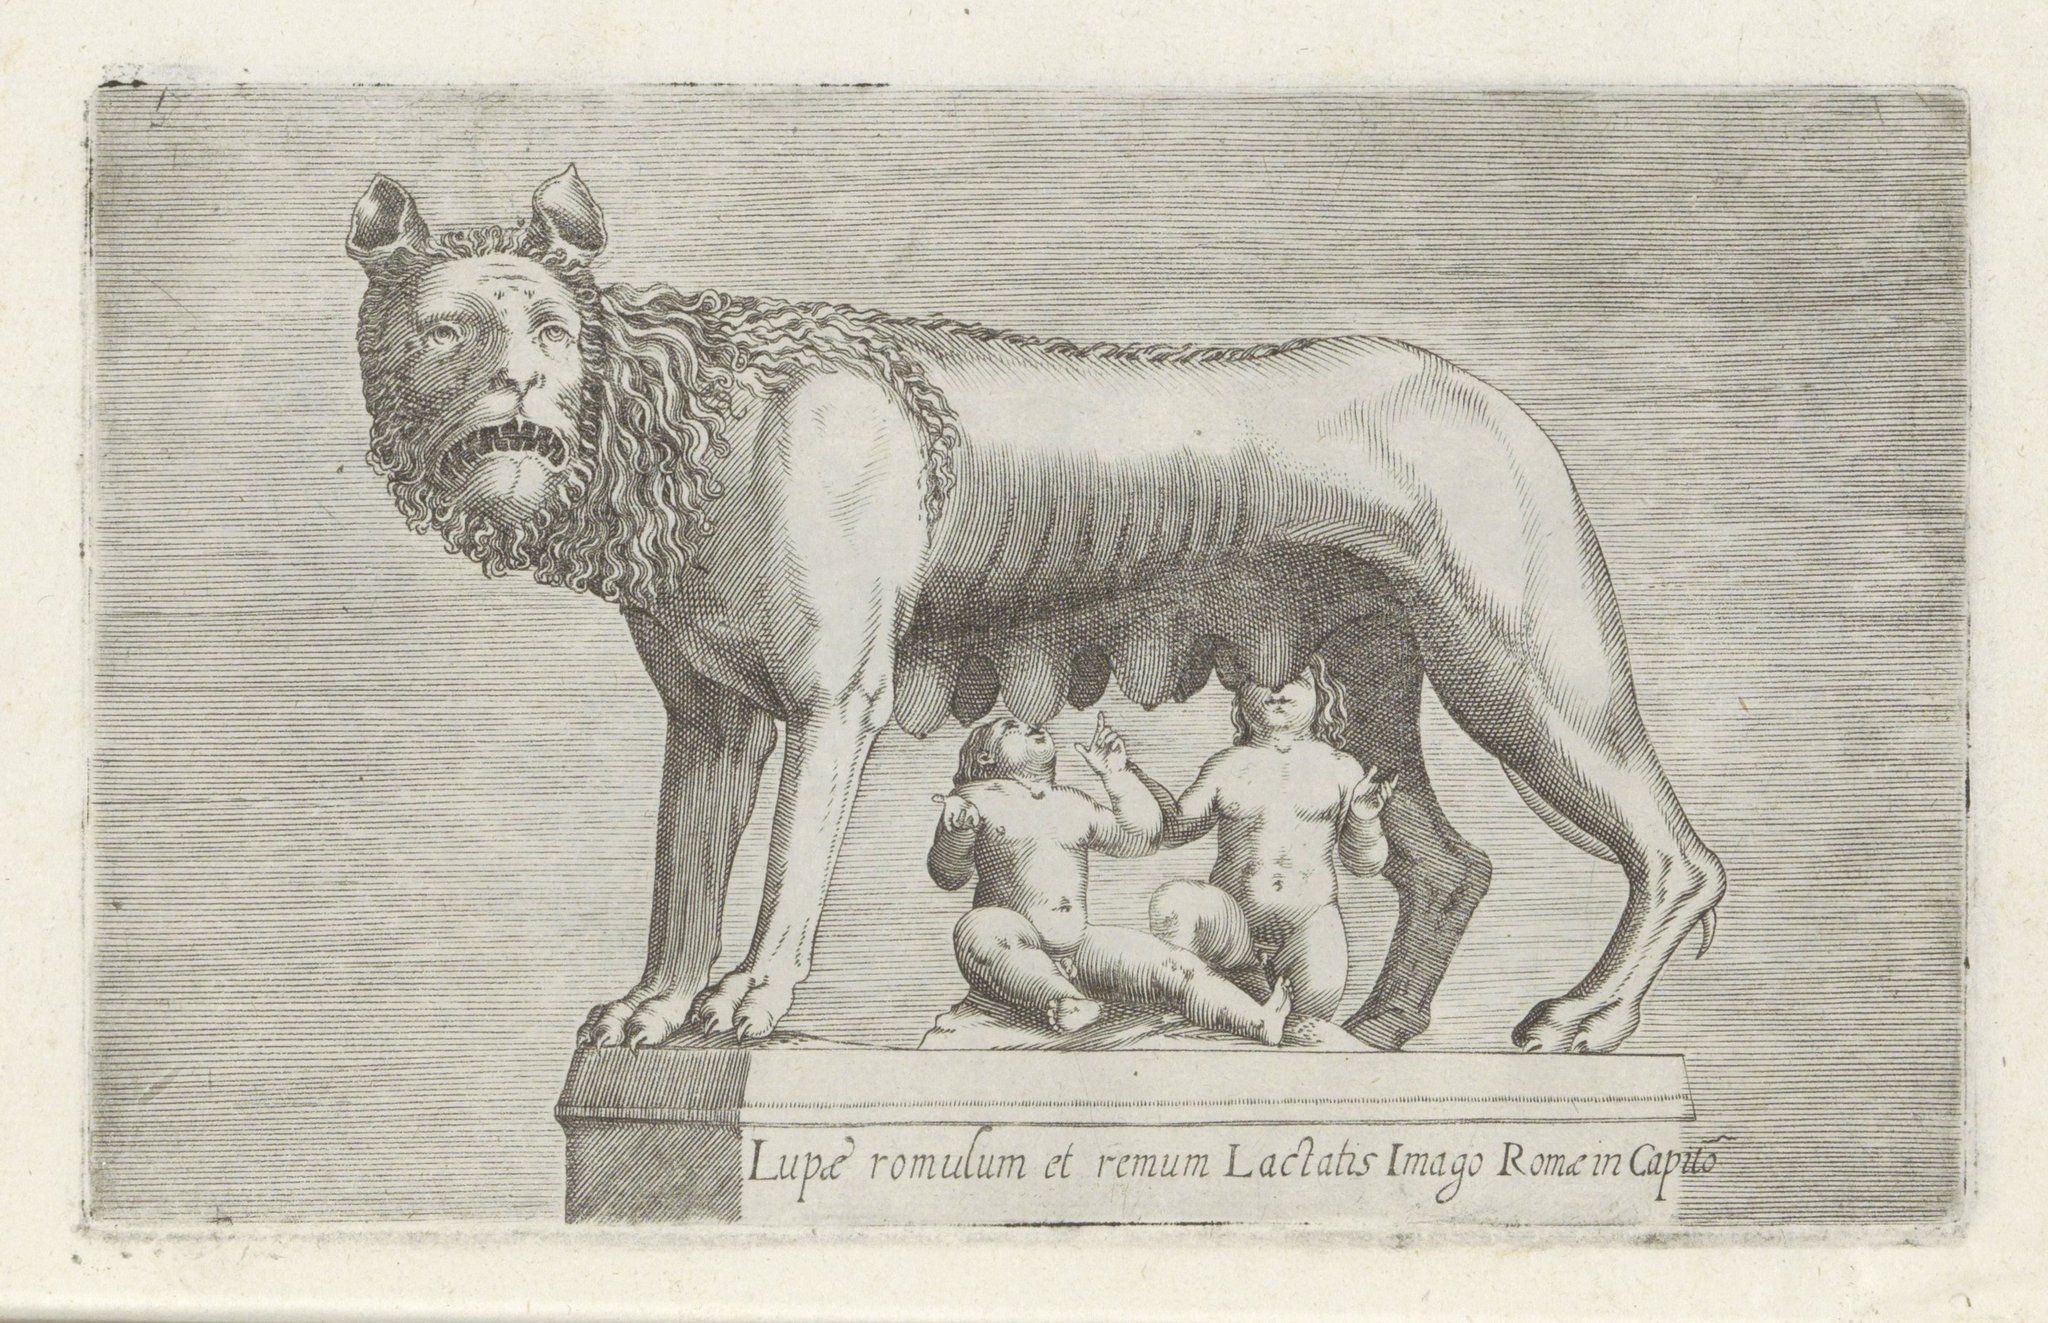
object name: print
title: Antiquarum statuarum urbis Romae quae in publicis locis visuntur icones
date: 1584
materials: paper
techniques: engraving, intaglio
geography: rome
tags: romulus and remus are washed ashore and suckled by a she-wolf; 'lupa romana', piece of sculpture, reproduction of a piece of sculpture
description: Naar een beeld in de Capitolijnse Musea te Rome. Deze prent maakt deel uit van een set van 79 prenten (+ titelprent) met voorstellingen van antieke sculpturen in Rome.